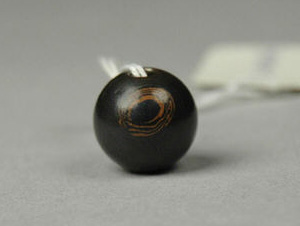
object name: ojime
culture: japanese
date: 1801-1900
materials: metal